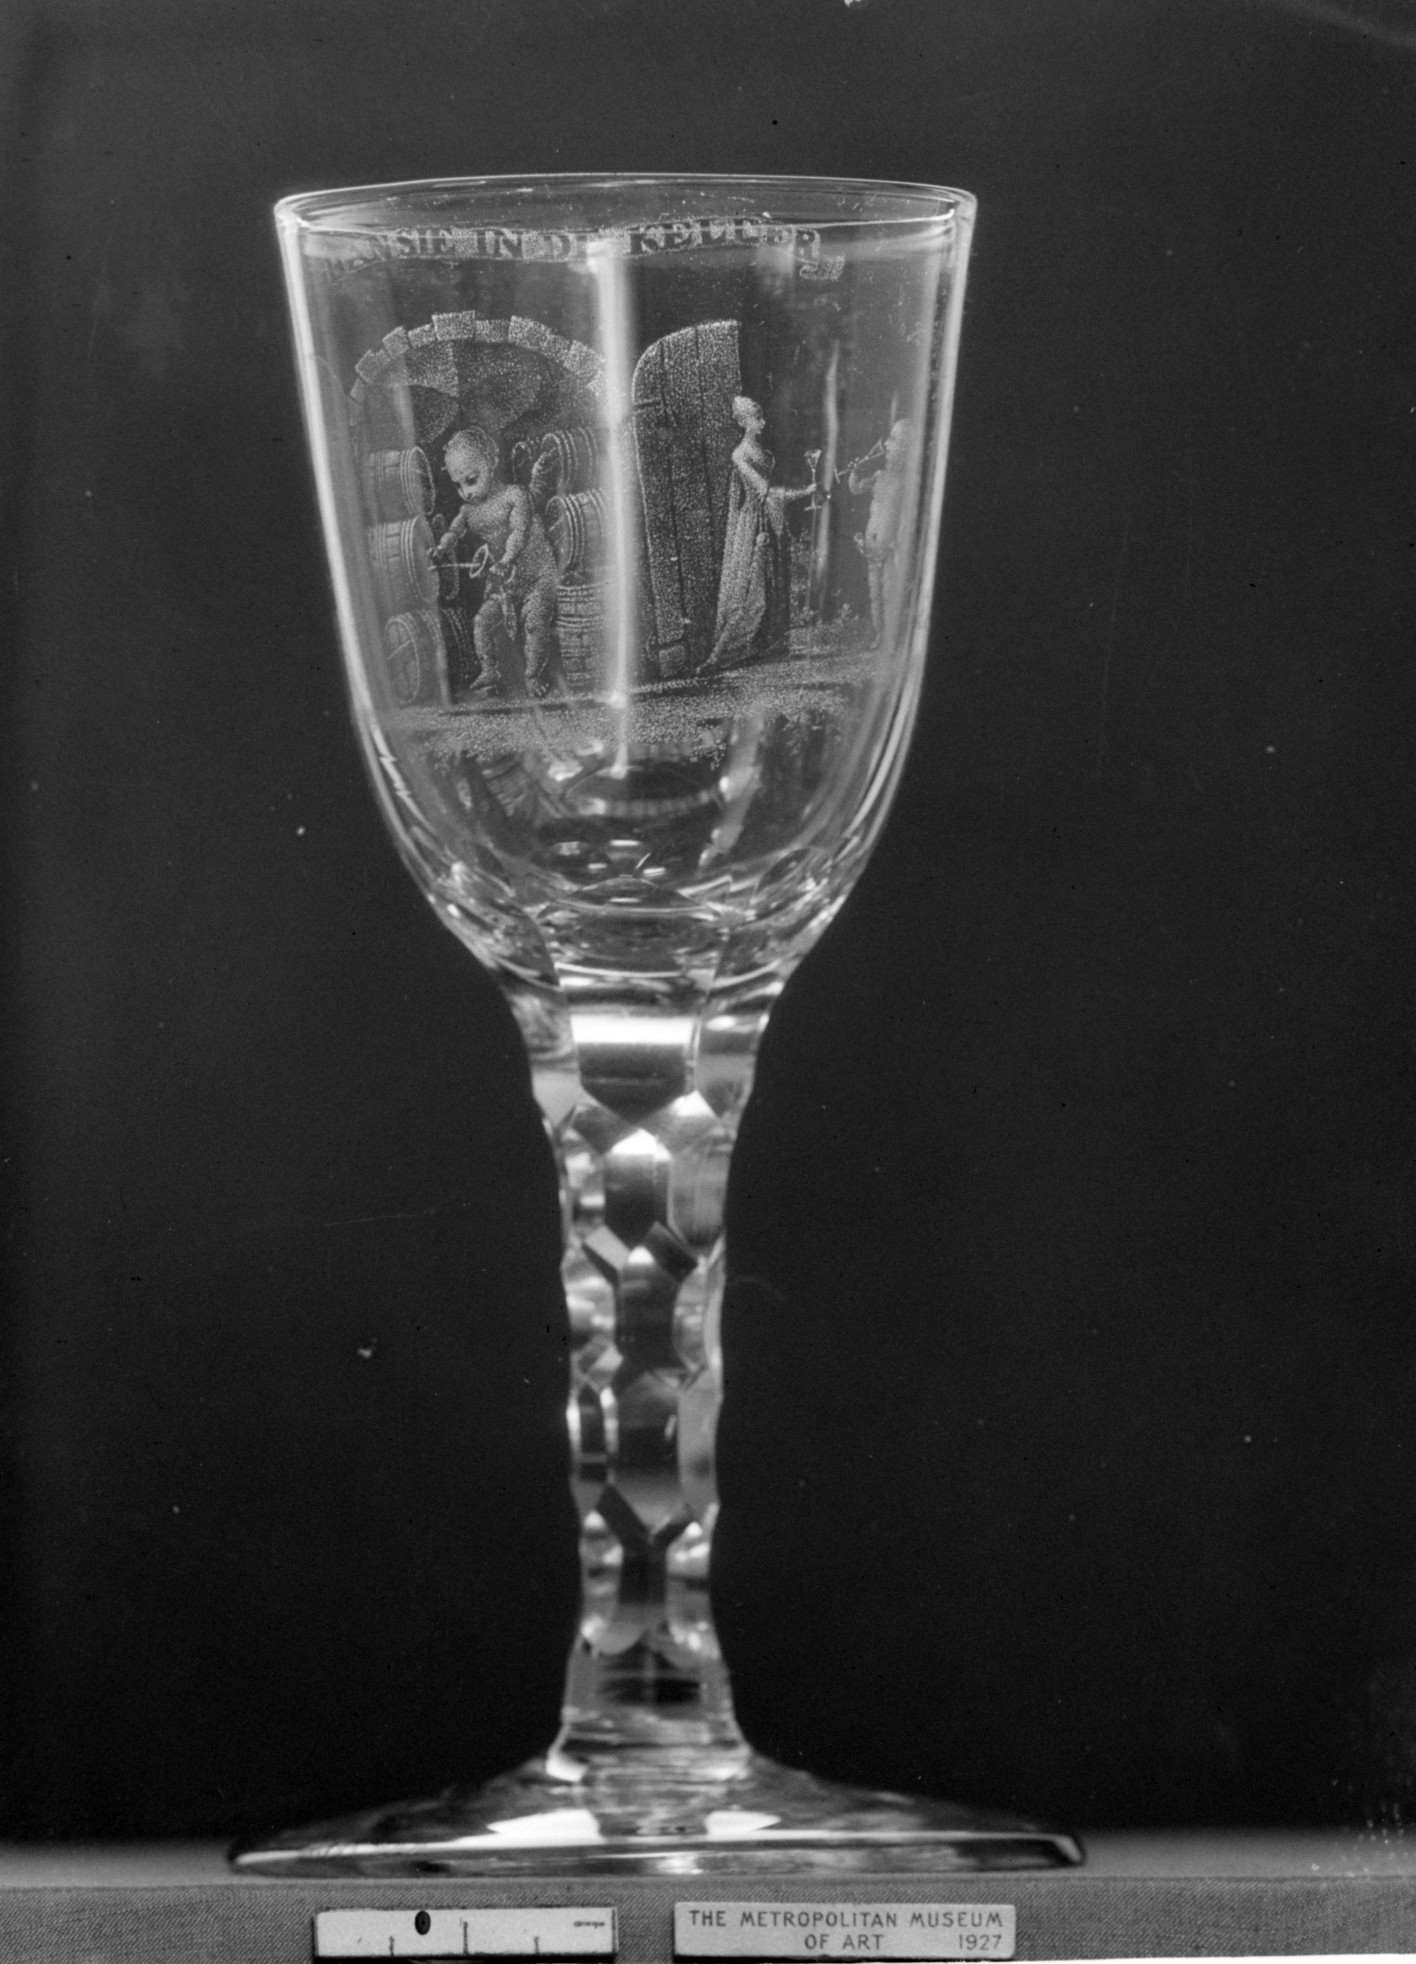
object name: wineglass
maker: david wolff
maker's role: engraver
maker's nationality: dutch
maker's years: 1732-1798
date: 1790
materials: glass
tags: women,cupid